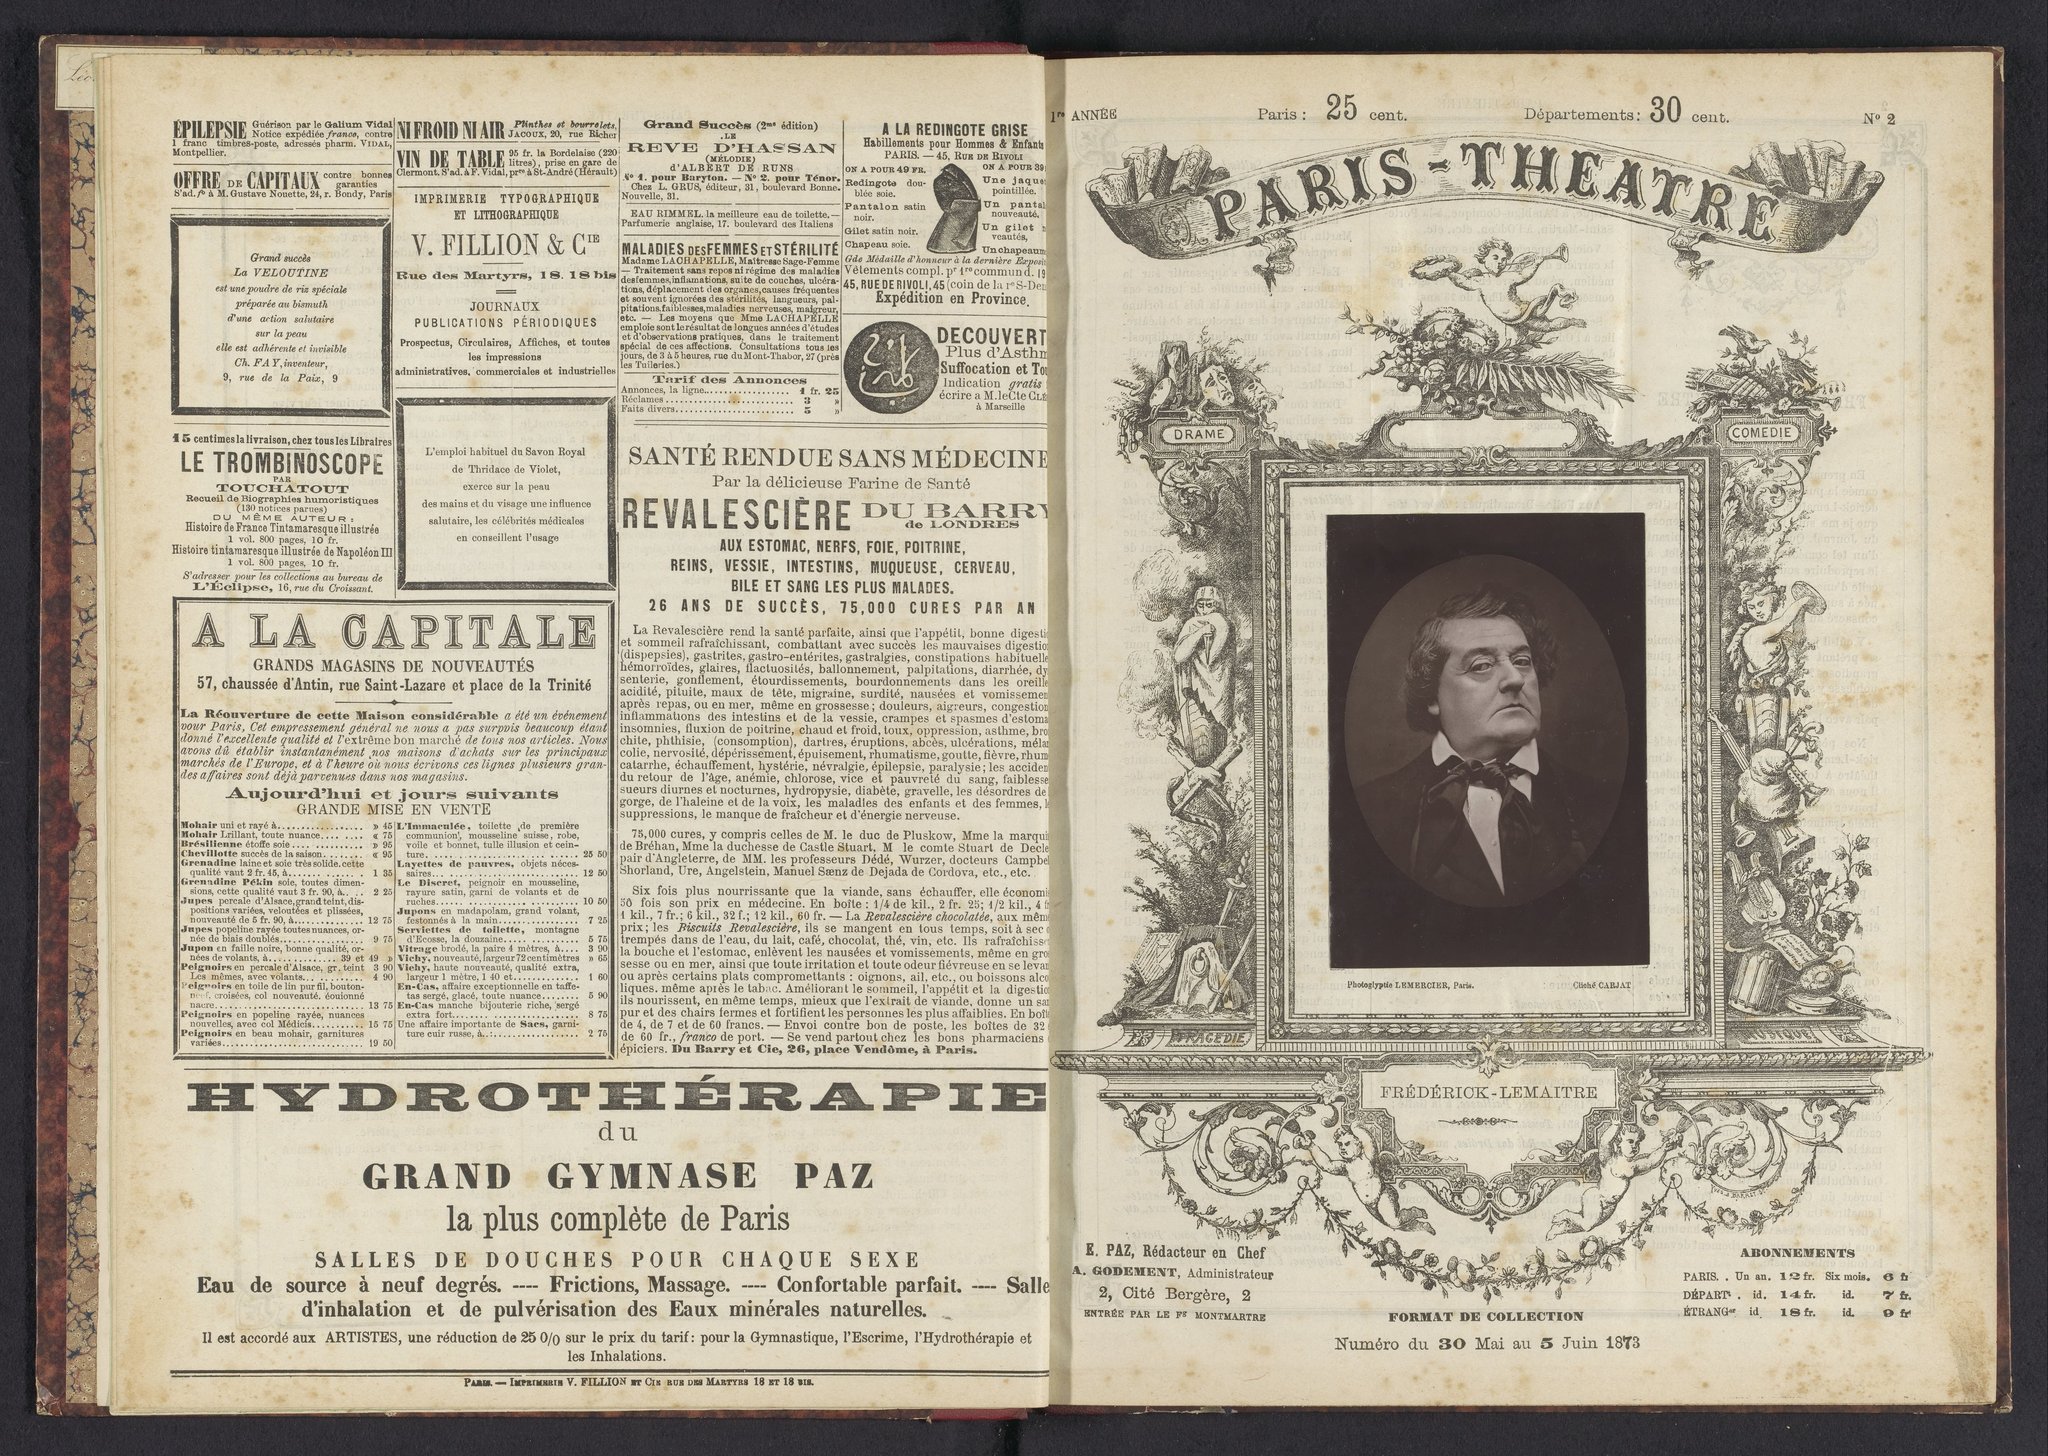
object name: photomechanical print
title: Frédérick-Lemaitre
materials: paper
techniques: woodburytype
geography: france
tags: adult man, actor (on the stage)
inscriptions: number: ‘No 2’, inscription: ‘Numéro du 30 Mai au 5 Juin 1873’